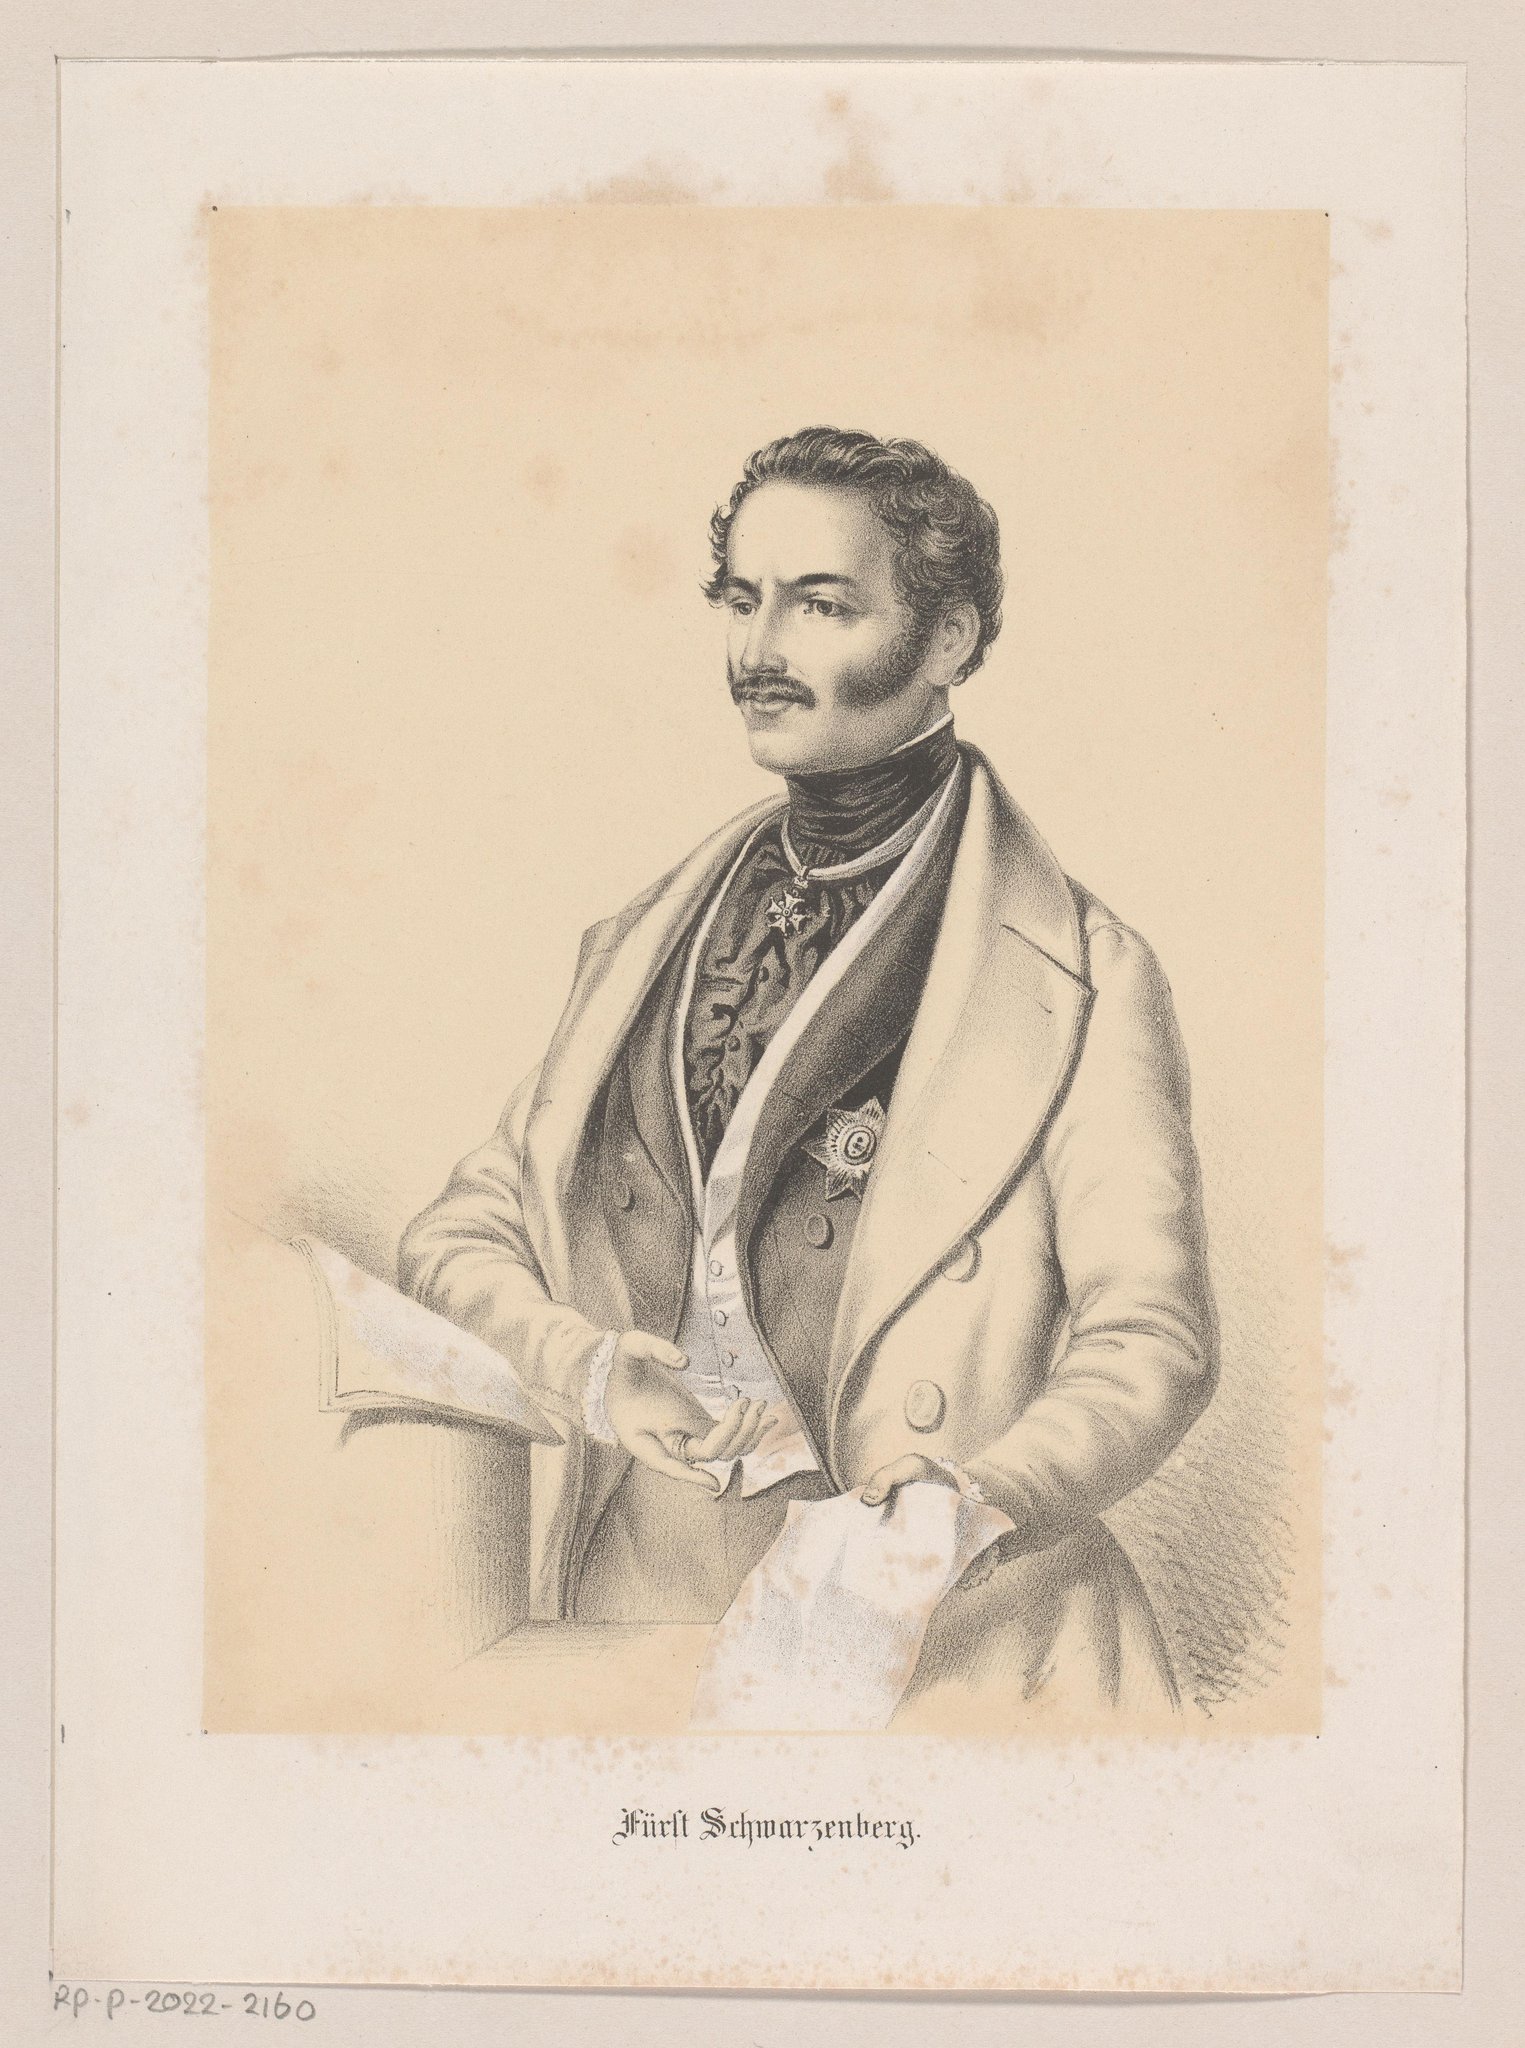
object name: print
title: Portret van Karl Philipp Borromäus zu Schwarzenberg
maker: Anonymous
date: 1832-1899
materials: paper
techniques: tone lithography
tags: politician, historical persons, politician, e.g. party leader